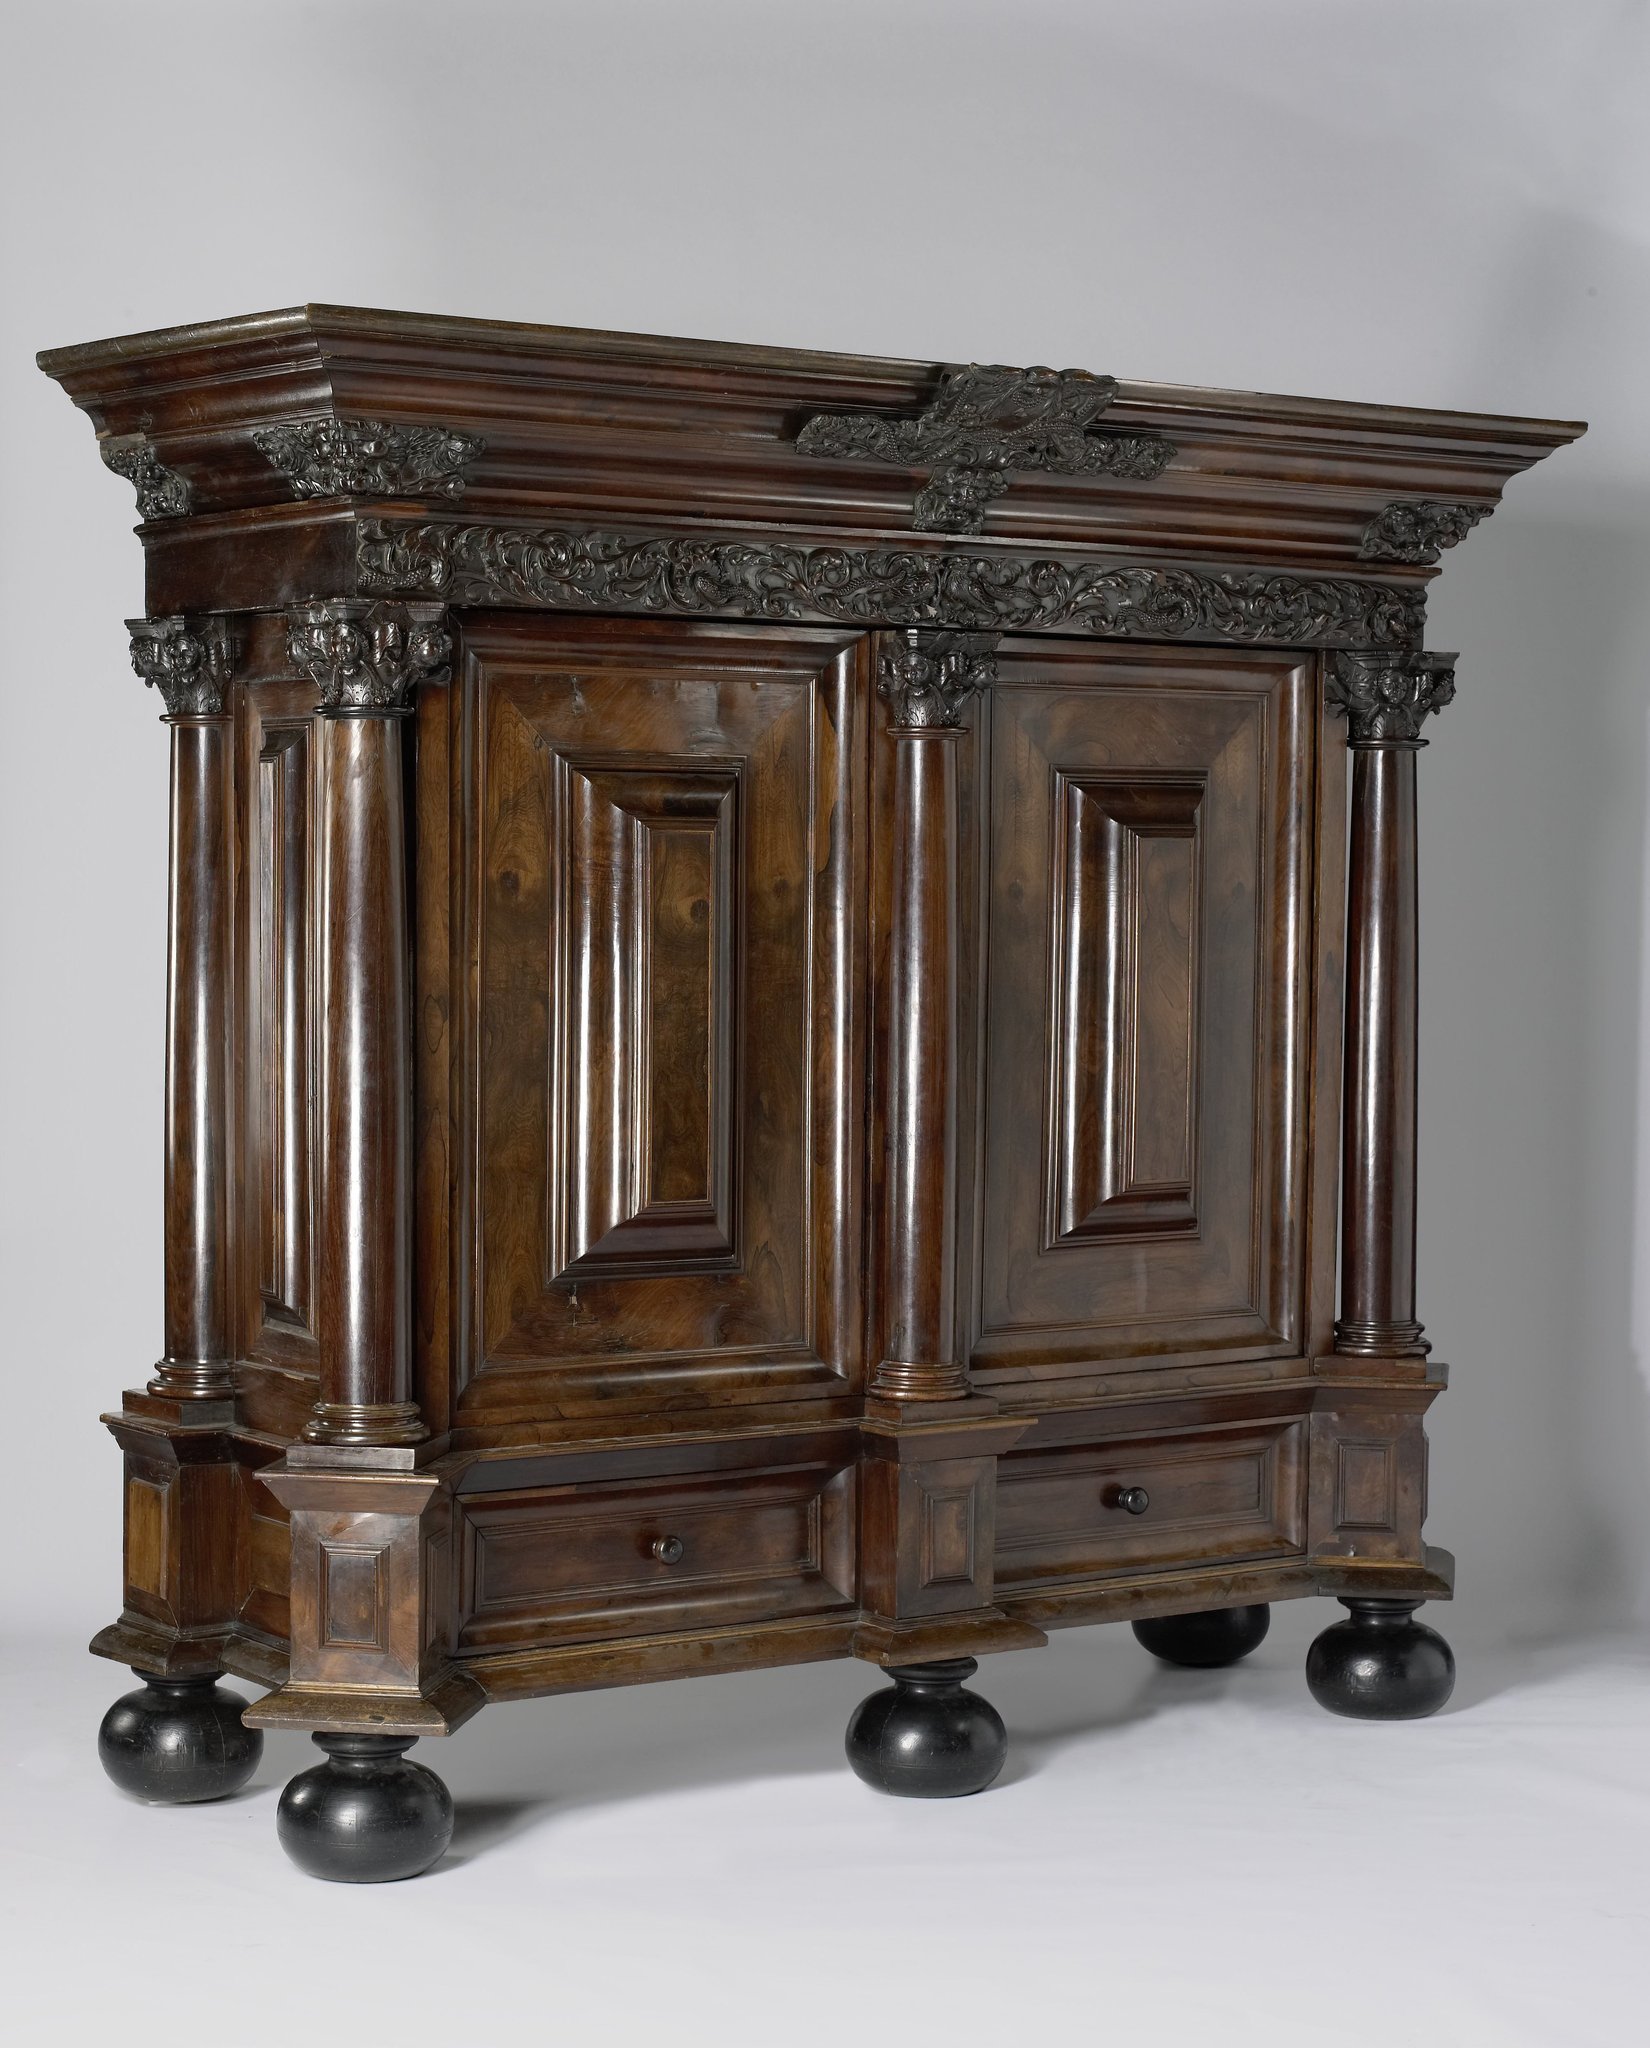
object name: furniture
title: Kussenkast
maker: Anonymous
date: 1650-1675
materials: wood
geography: netherlands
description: Cupboard. Oak, veneered with rosewood. Northern Netherlands, 2nd half 17th century.